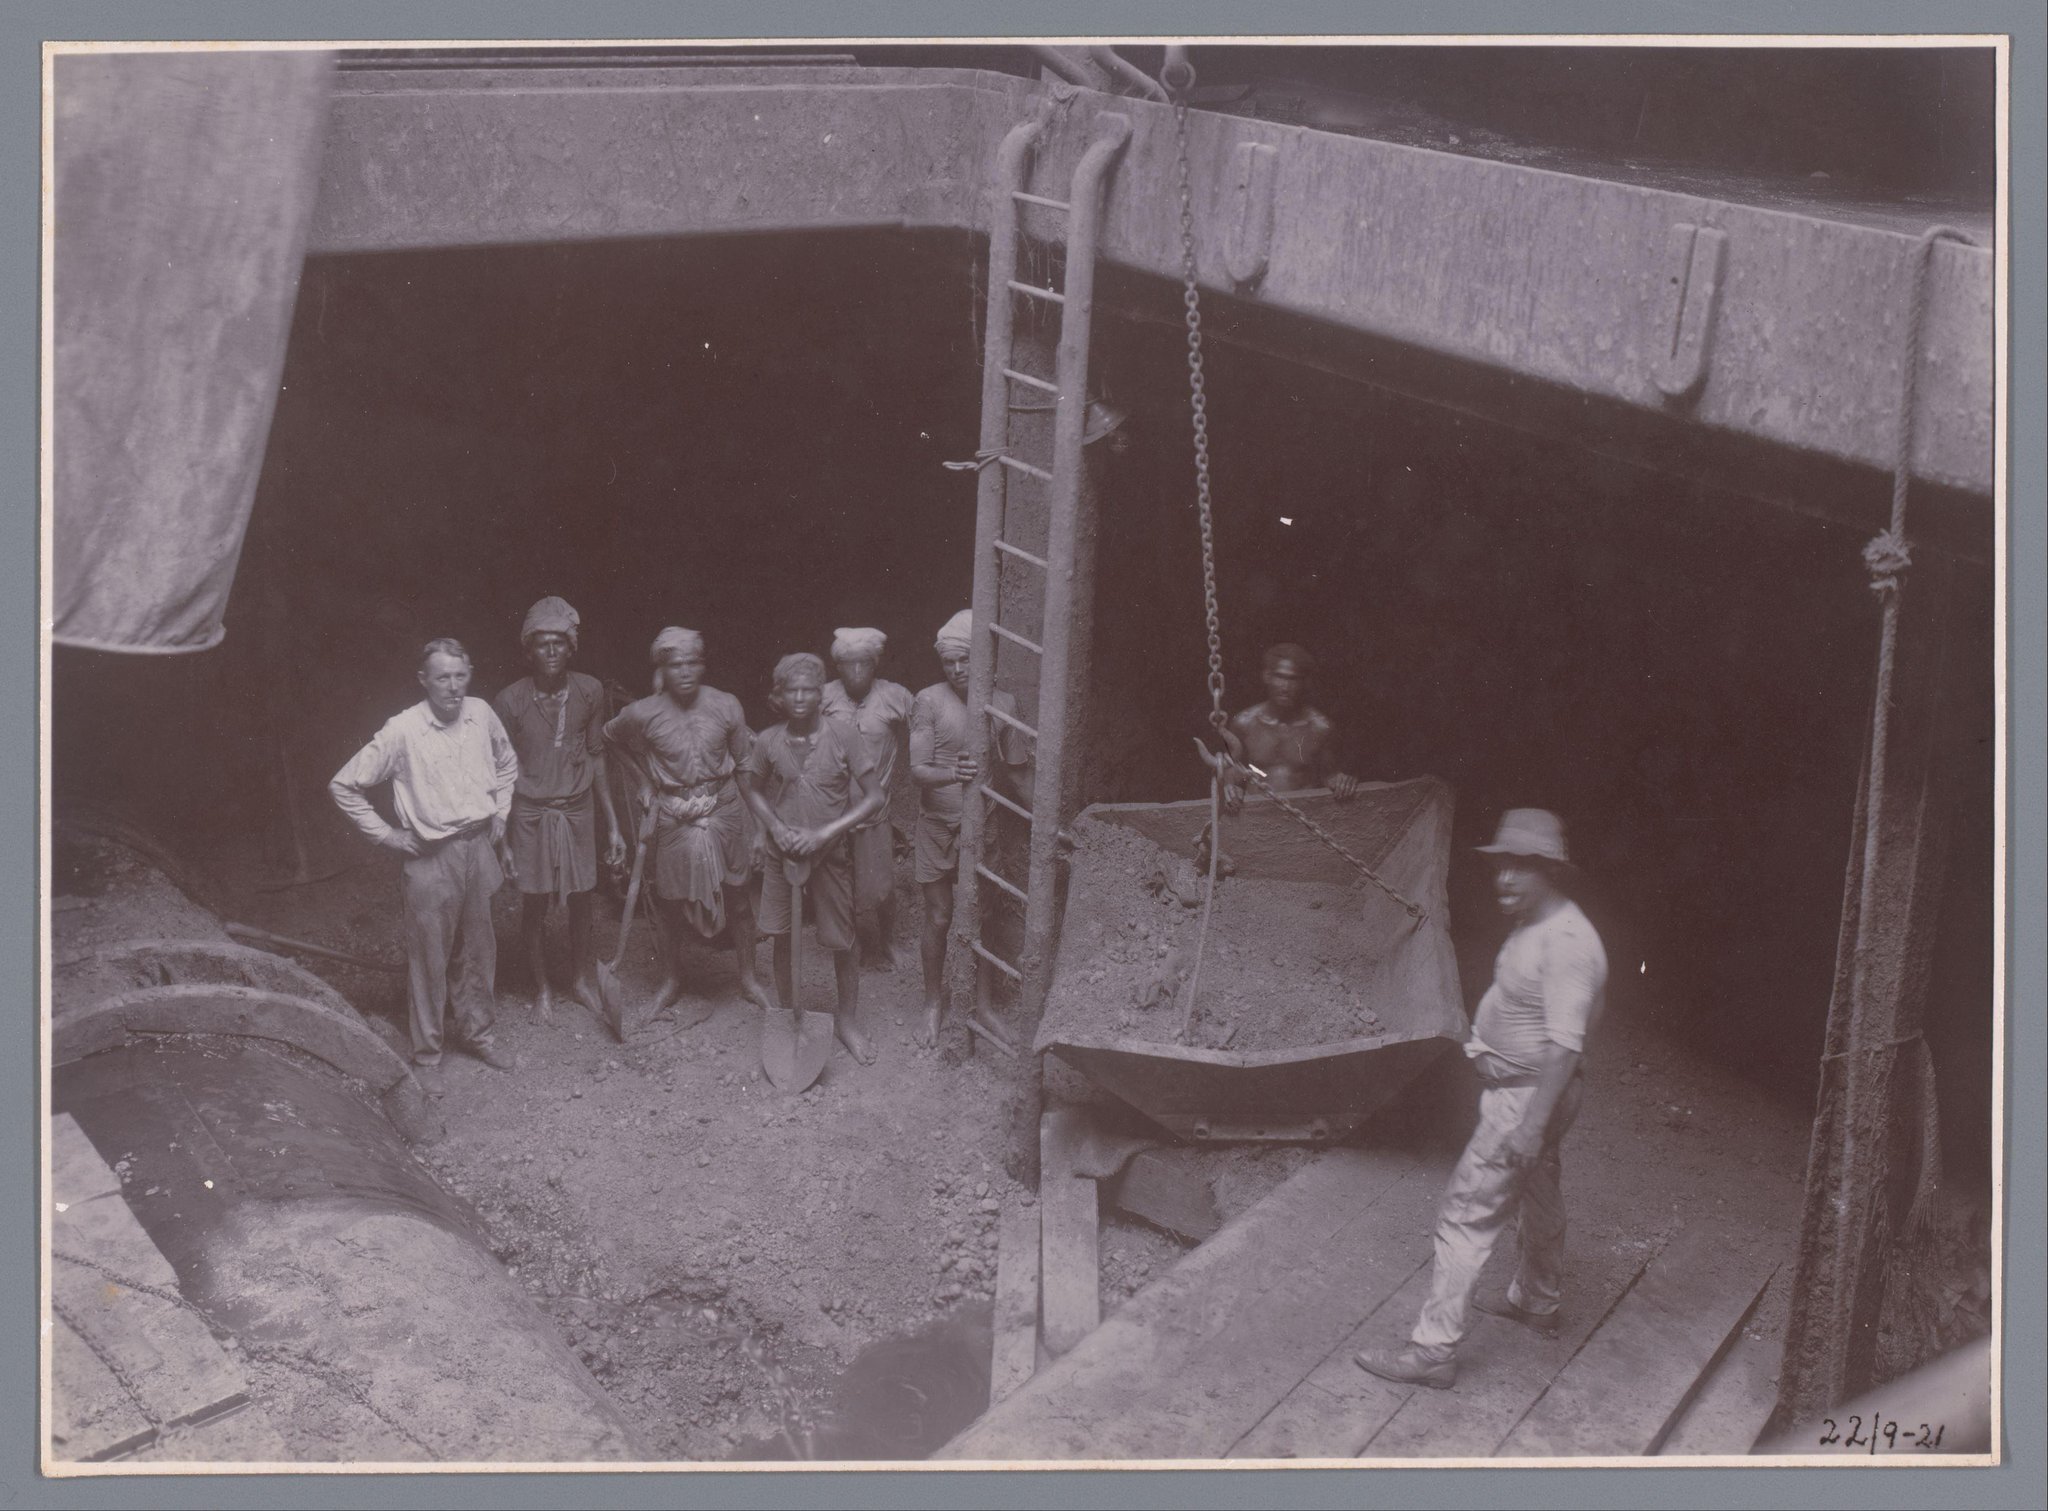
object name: photograph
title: Erts in ruim IV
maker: Anonymous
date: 1921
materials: photographic support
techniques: gelatin silver print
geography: belawan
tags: crew ~ ship, steamsailer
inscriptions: date: ‘22/09-21’, inscription: ‘Erts in ruim IV’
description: Kijkje in het ruim waar het te lossen erts ligt. Rond de laadbak staan de Indonesische arbeiders en enkele Europese opzichters, september 1921. Ongenummerd. Onderdeel van de groep van losse foto's over de aanleg van de haven Belawan aan de kust voor Medan, Sumatra 1921-1922.